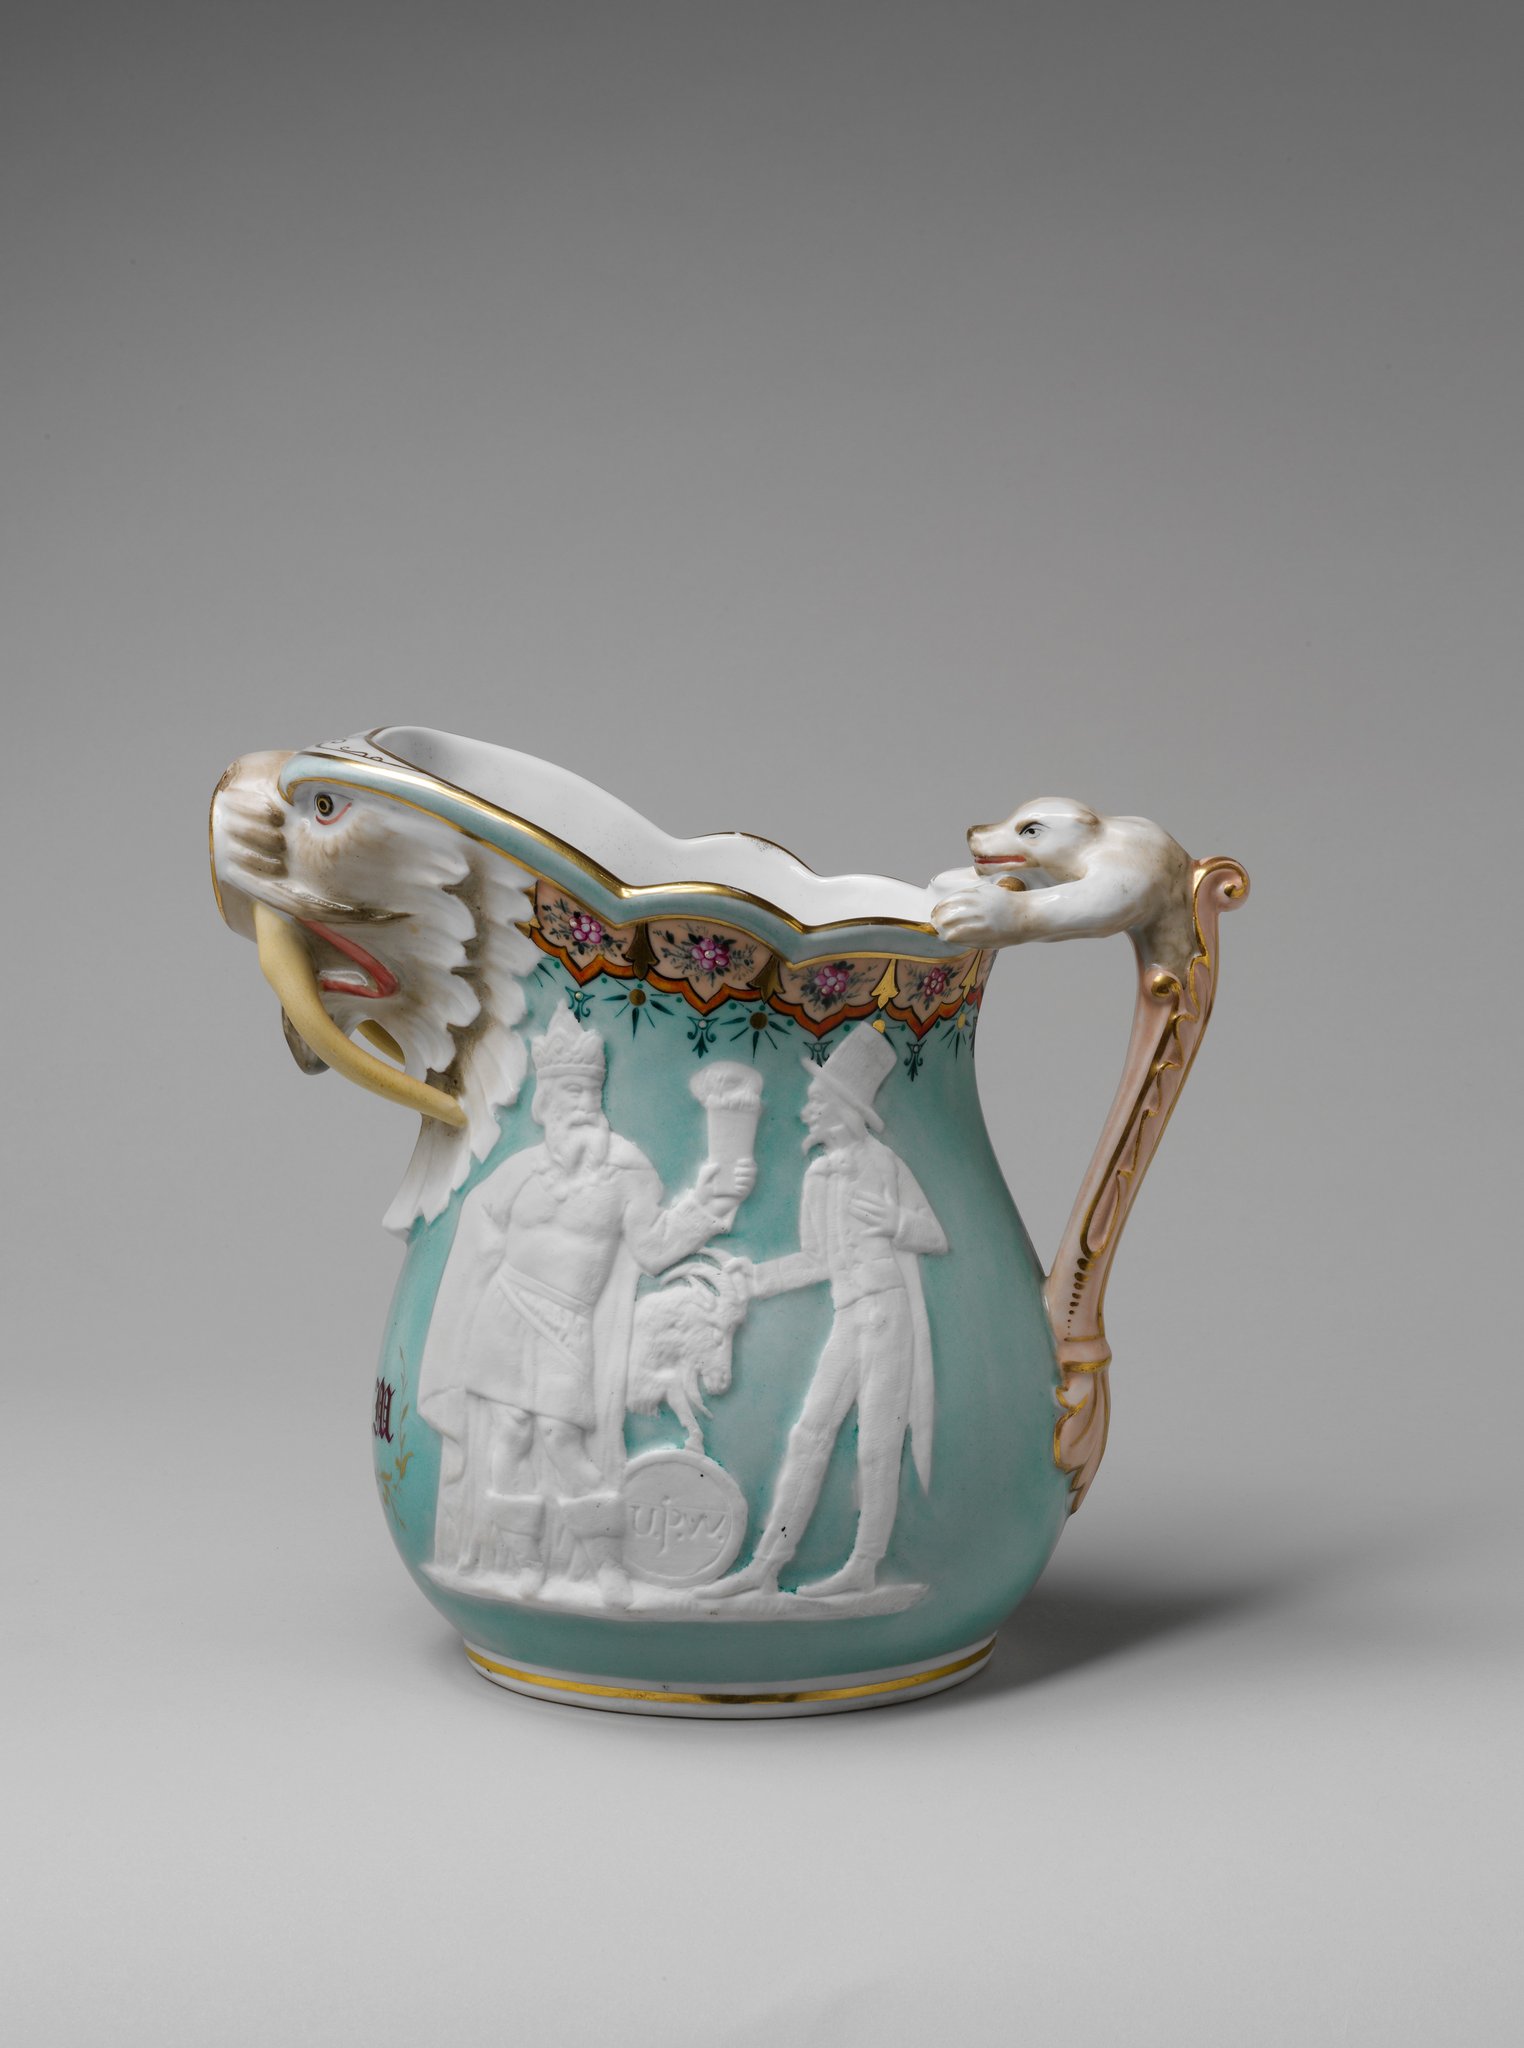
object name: pitcher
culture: american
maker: union porcelain works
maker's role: maker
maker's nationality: american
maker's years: 1863-1922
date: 1875-1885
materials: porcelain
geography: united states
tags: men,playing cards